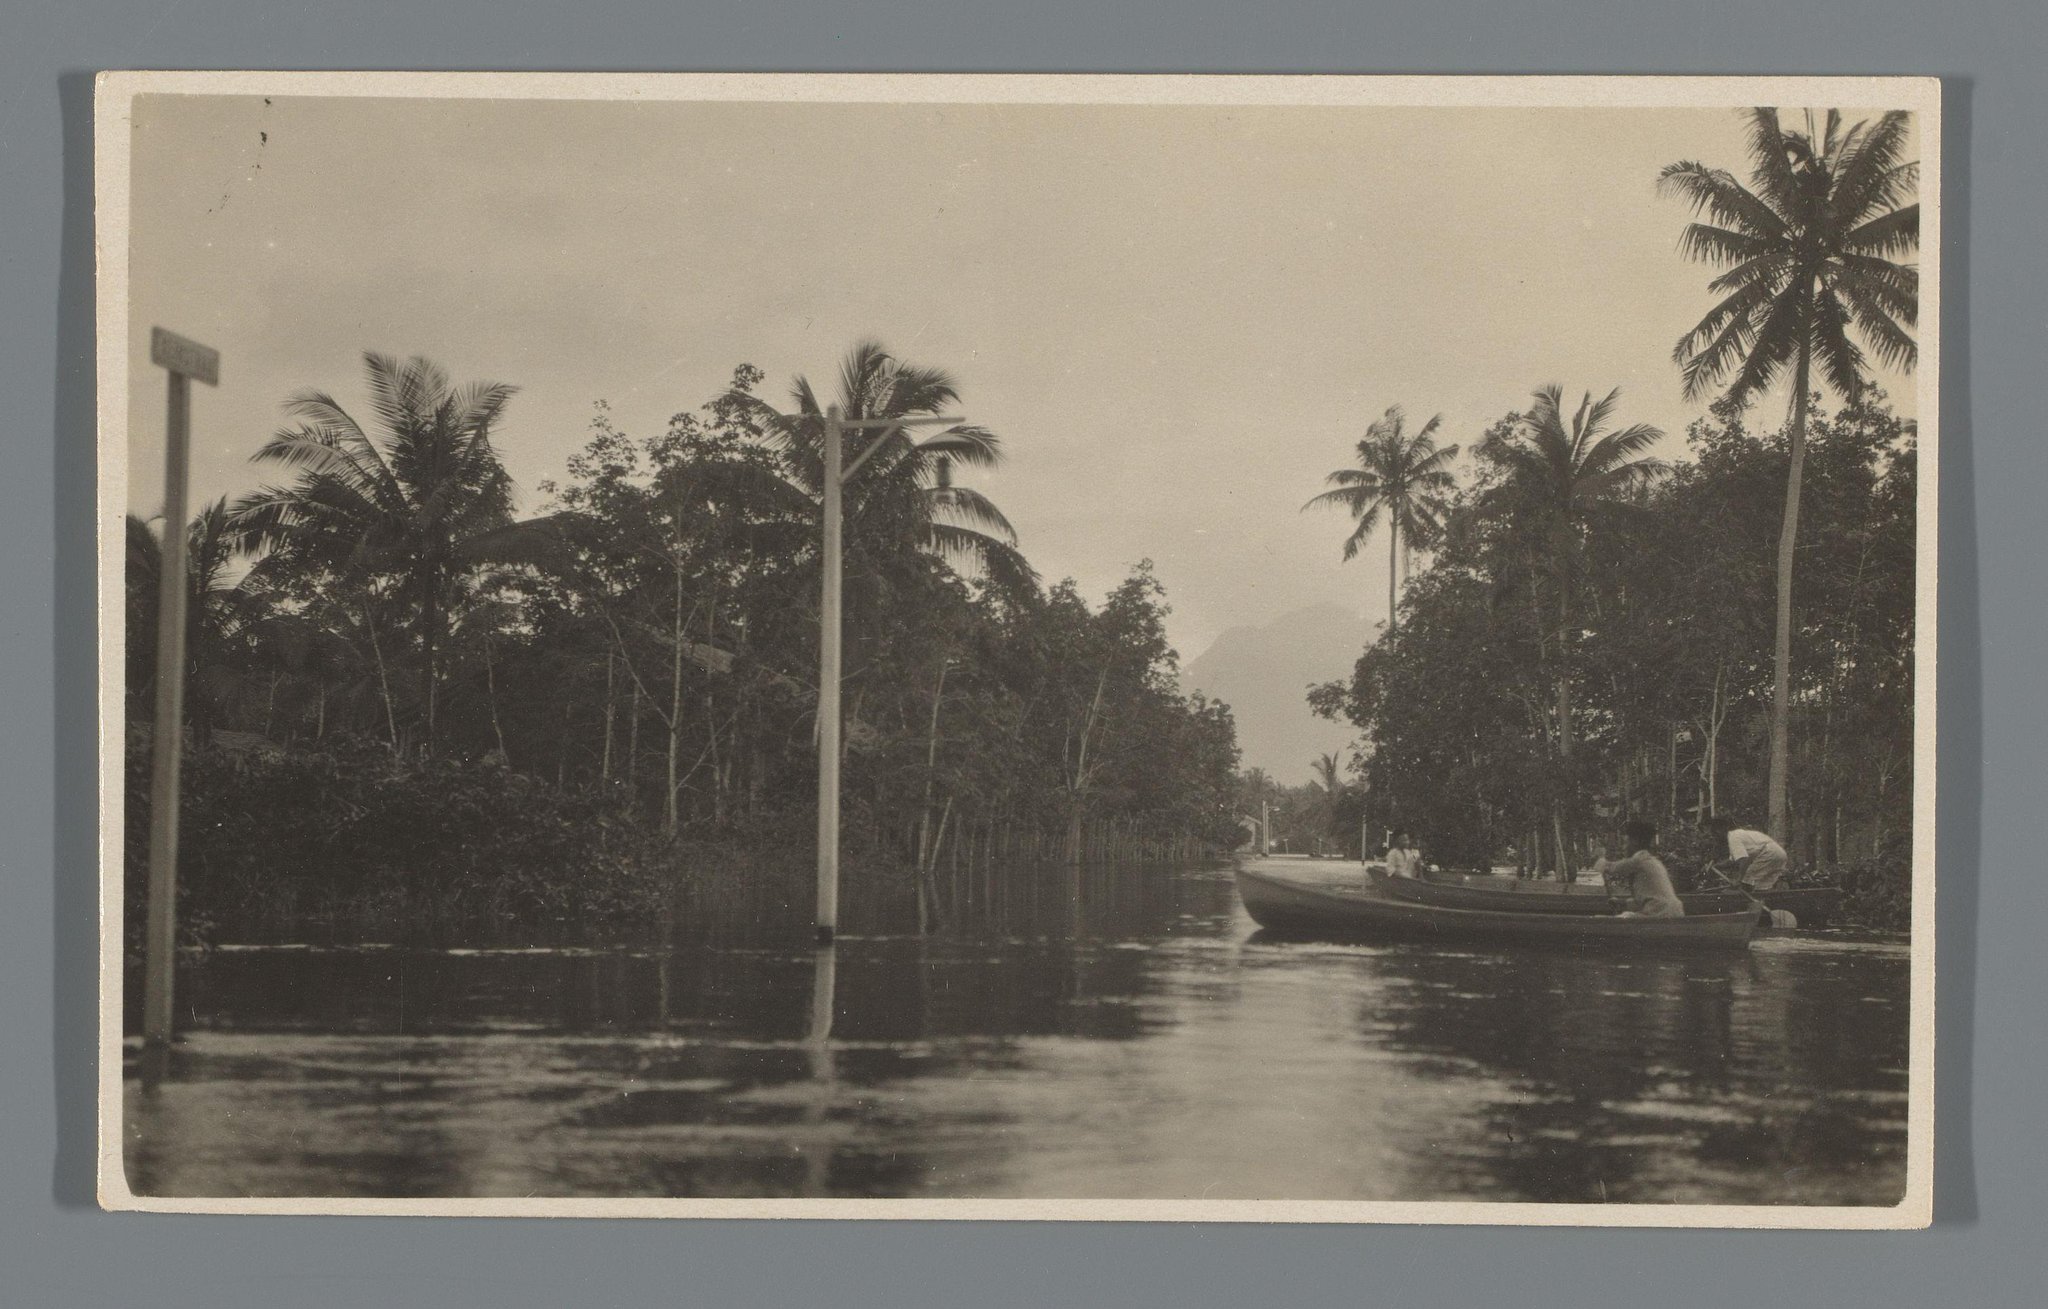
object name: photograph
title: Boten varen door de overstroomde straten van Singkawang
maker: Anonymous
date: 1920-1940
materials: photographic support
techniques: gelatin silver print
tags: borneo